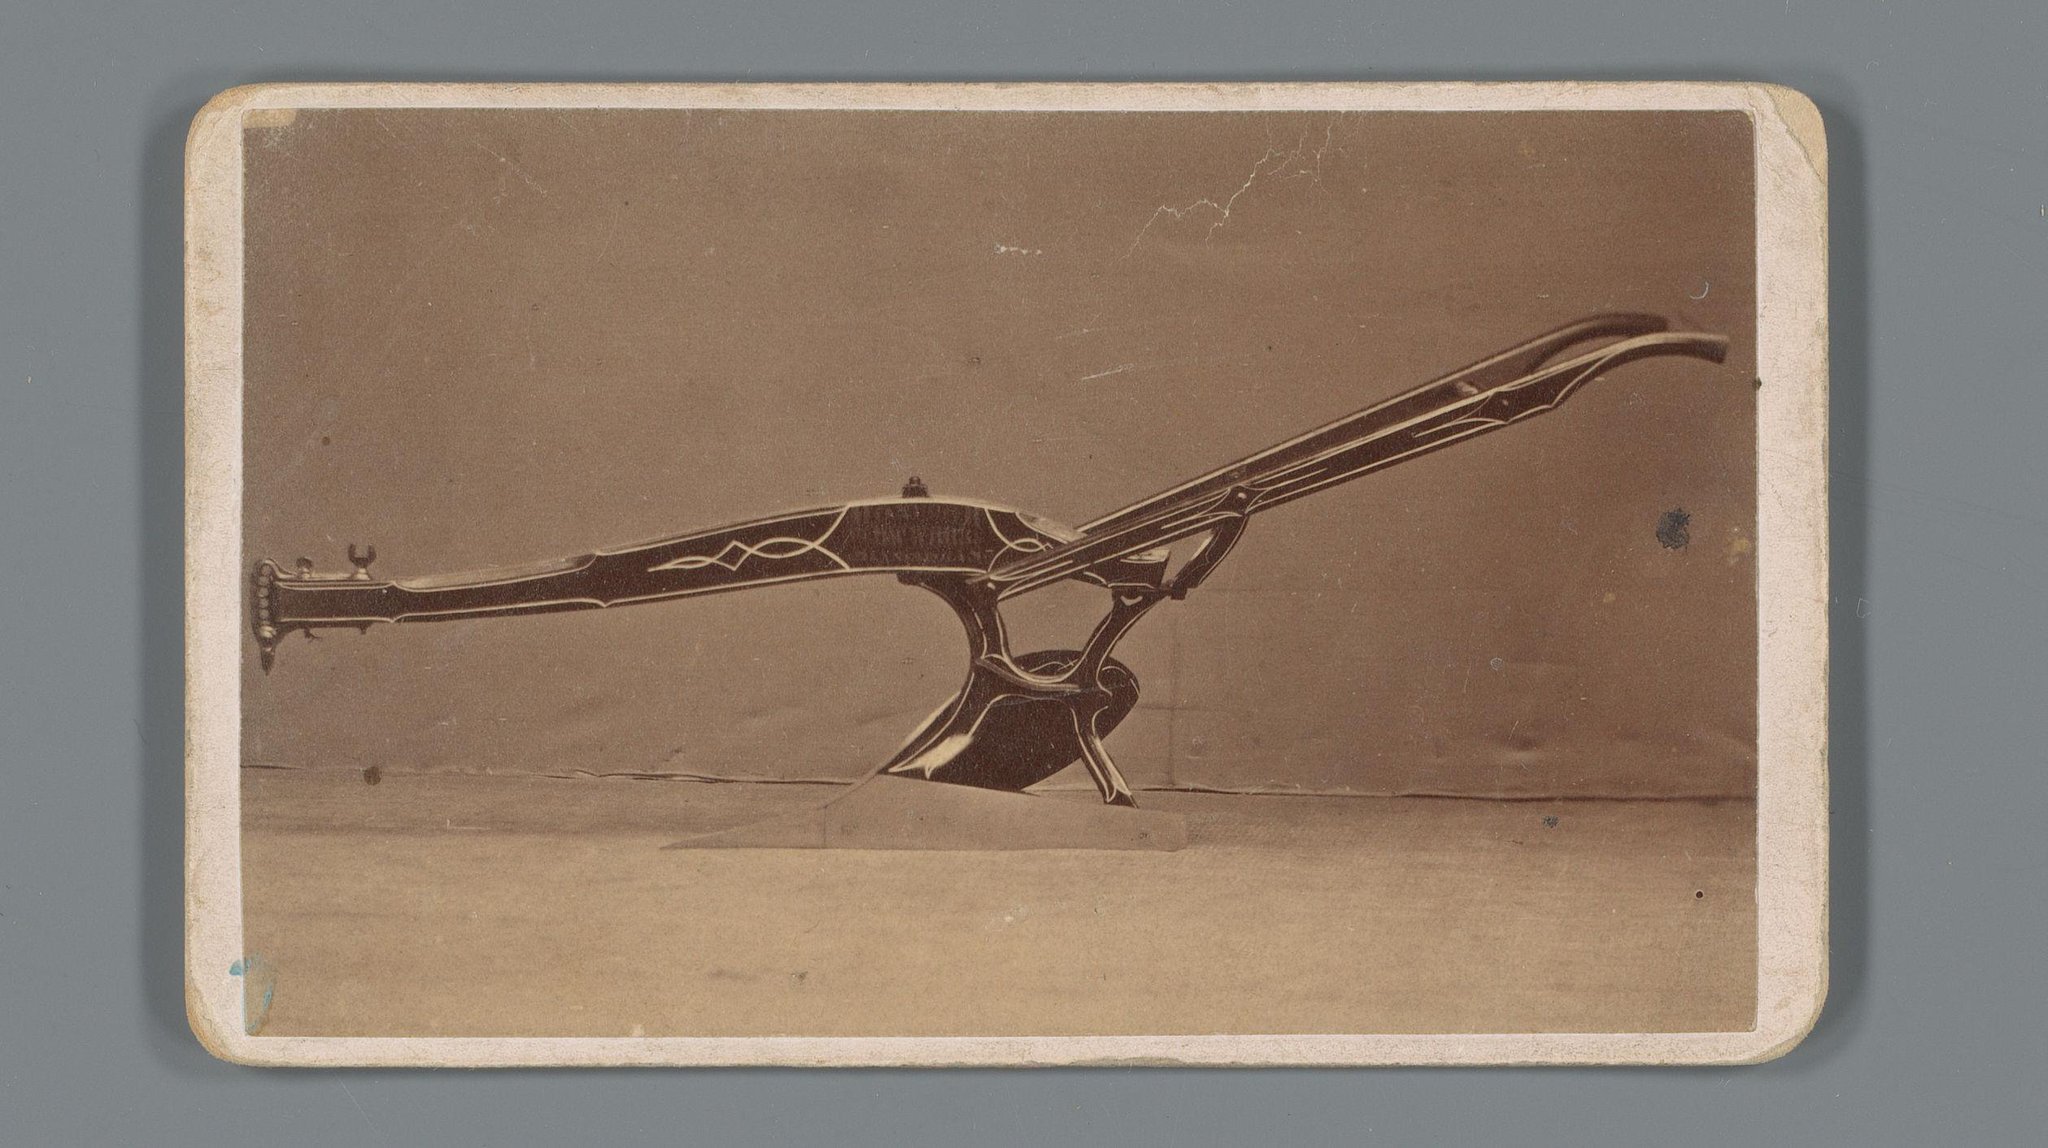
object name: photograph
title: Reclame voor een ploeg van Minnesota Plow Works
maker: m. nowack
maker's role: fotograaf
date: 1865-1900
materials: cardboard, photographic support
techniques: albumen print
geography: minneapolis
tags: advertising, agricultural implements: plough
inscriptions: inscription: ‘MINNESOTA PLOW WORKS’, inscription: ‘MINNE-HA-HA/ GALLERY/ M. NOWACK, Wholesale and Retil/ Dealer in/ Photographs/ and Views./ 117, Wash. Av. N./ MINNEAPOLIS, MINN./ NEGATIVES PRESERVED./ Duplicates can be had at any time by giving name.’